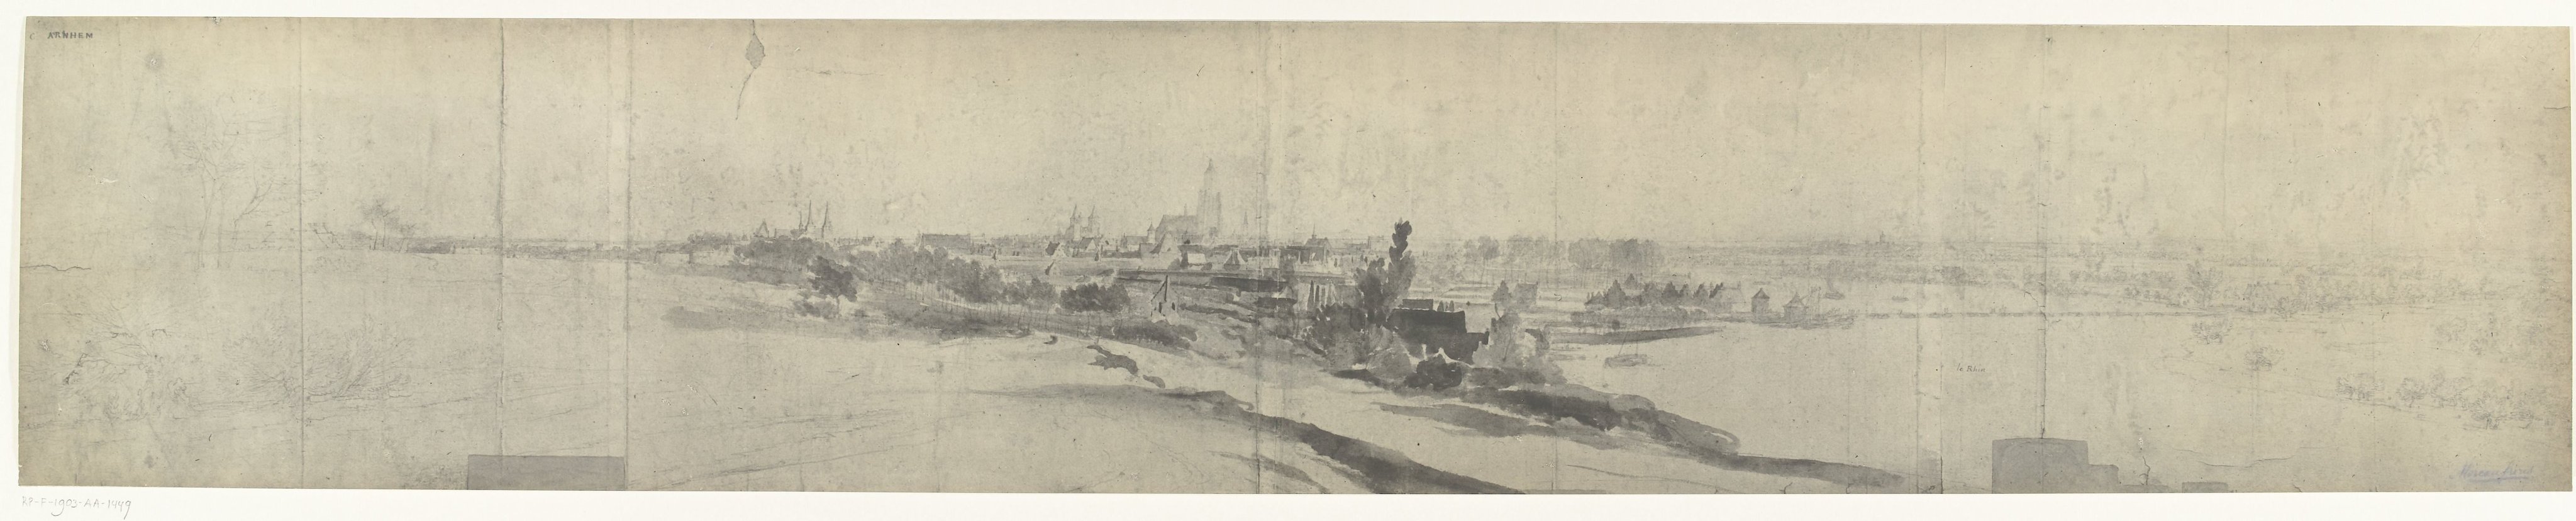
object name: photograph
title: Foto's van tekeningen van de Franse inval in de Nederlanden in 1672 door Adam Frans van der Meulen bewaard in de Manufacture des Gobelins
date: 1900-1903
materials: paper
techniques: gelatin silver print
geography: france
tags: lodewijk xiv (koning van frankrijk), prospect of city, town panorama, silhouette of city, arnhem, rampjaar (disaster year)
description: Niet in Frederik Muller; door het RPK toegevoegd nummer. Onderdeel van een groep van ca. 50 foto's van tekeningen van de Franse inval in de Nederlanden in 1672 door Adam Frans van der Meulen, bewaard in de Manufacture Nationale des Gobelins te Parijs.